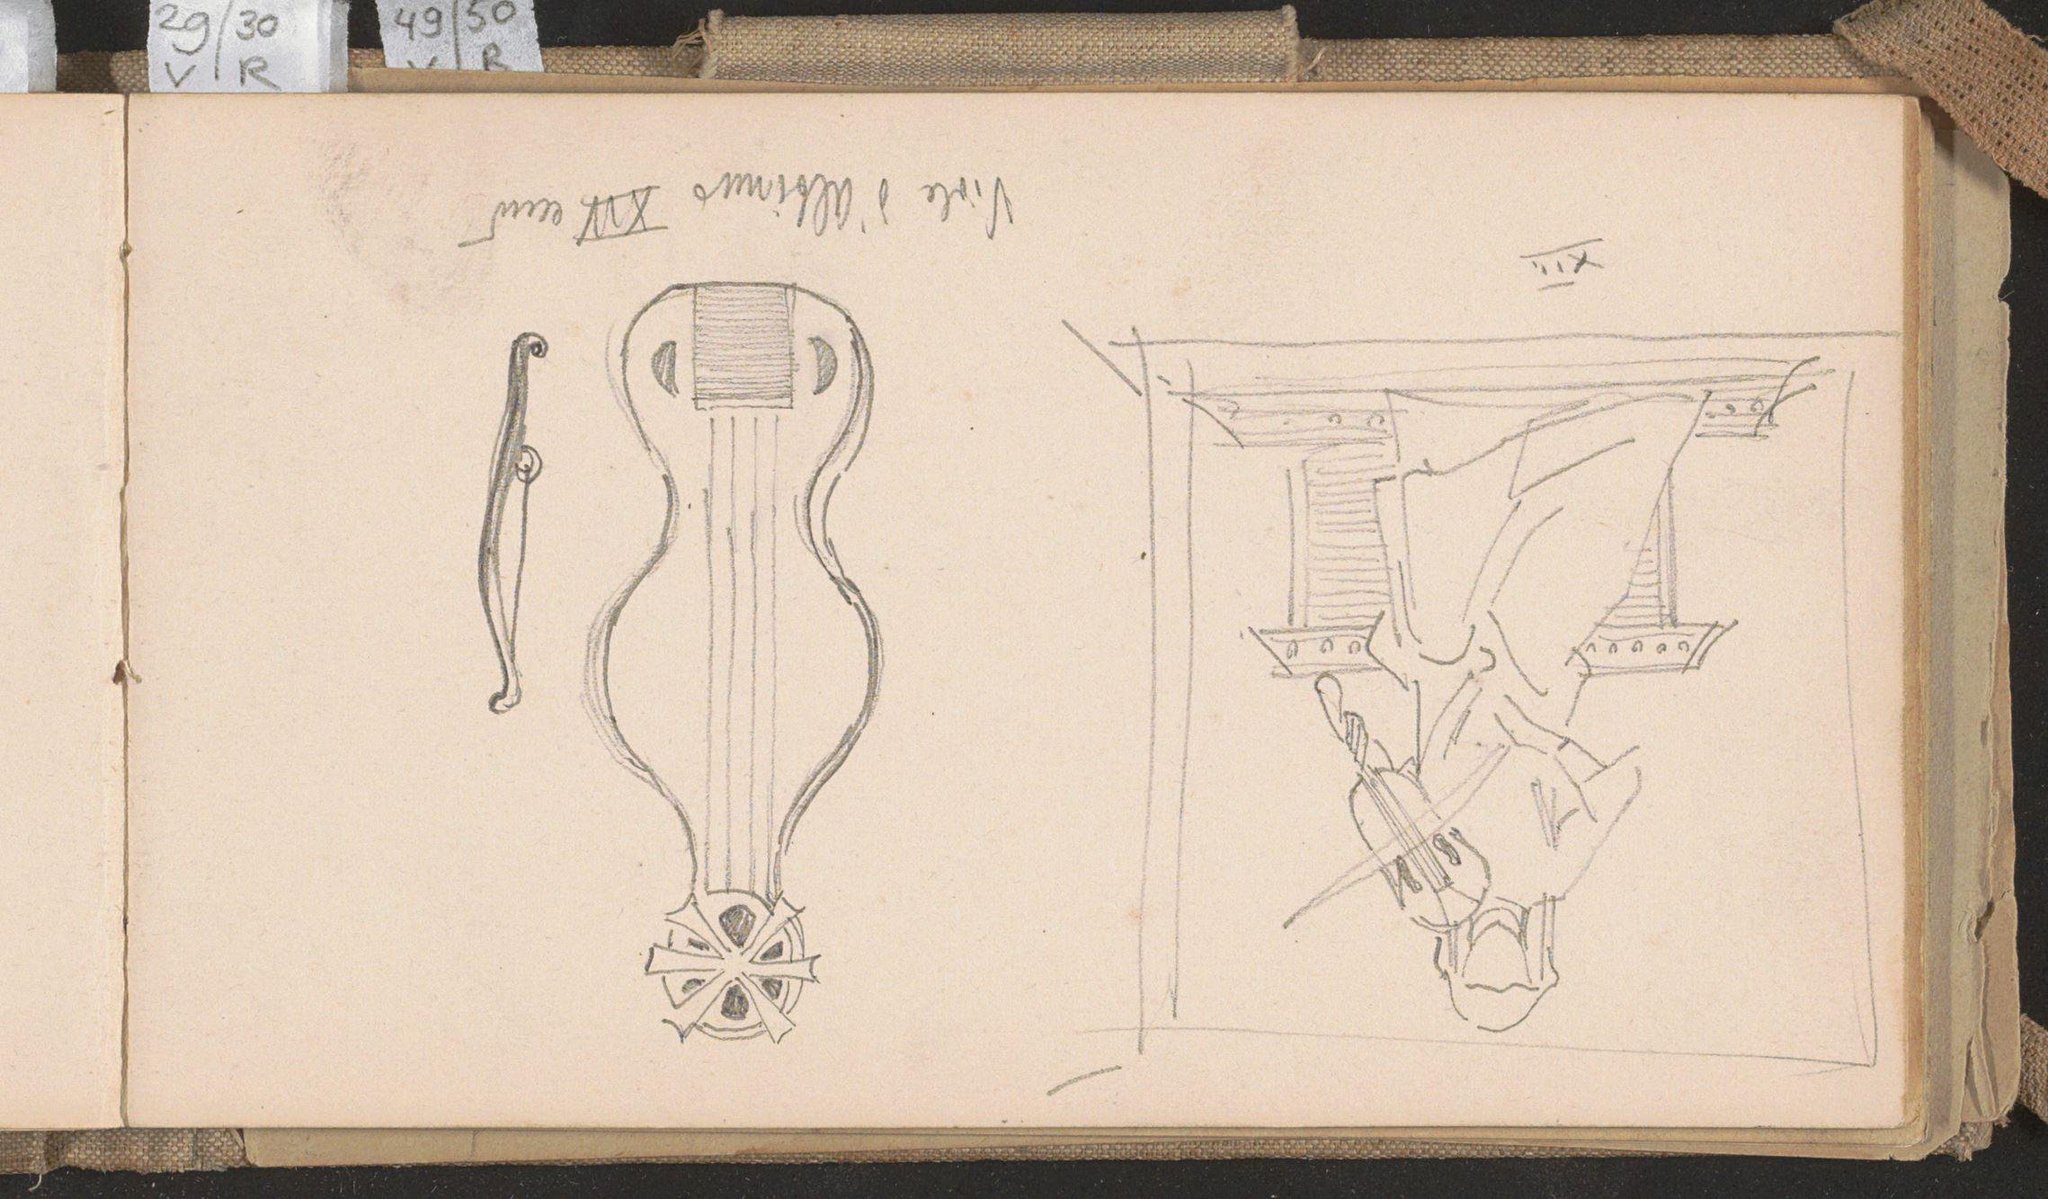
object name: sketchbook leaf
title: Viool uit de veertiende eeuw na Christus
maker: antoon derkinderen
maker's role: draughtsman, painter, print maker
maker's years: 1859-1925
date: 1892-1901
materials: paper, pencil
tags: violin, fiddle, historical costume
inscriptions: annotation: ‘XII?/ Viole d'Albinus XIV eeuw’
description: Tevens een studie van een vrouw in middeleeuws kostuum die viool speelt. Blad 28 recto uit een schetsboek met 51 bladen.